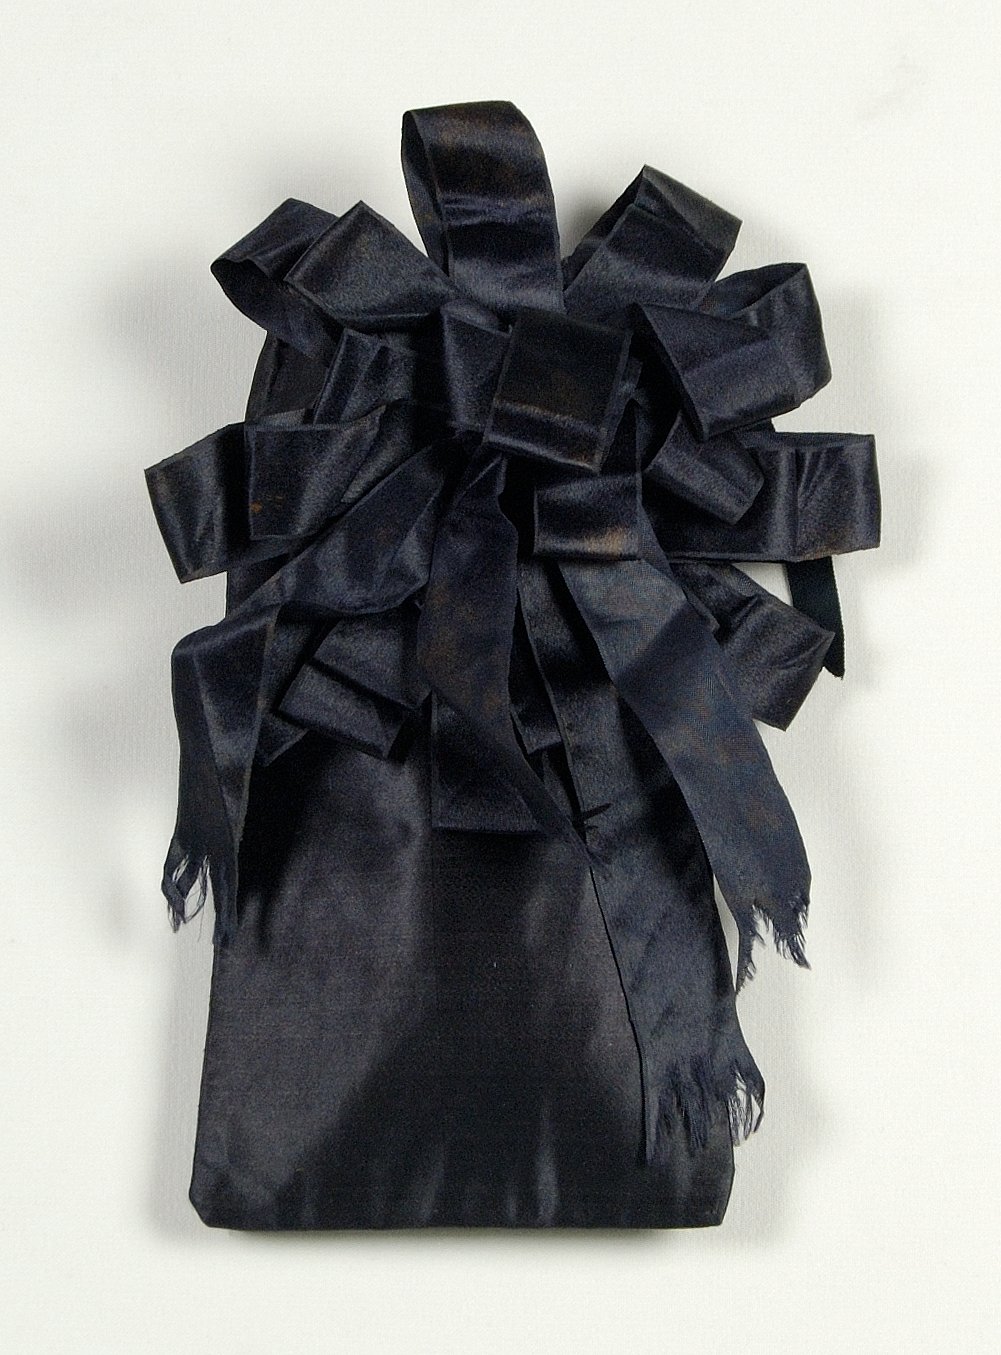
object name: wig bag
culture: british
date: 1830-1840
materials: silk